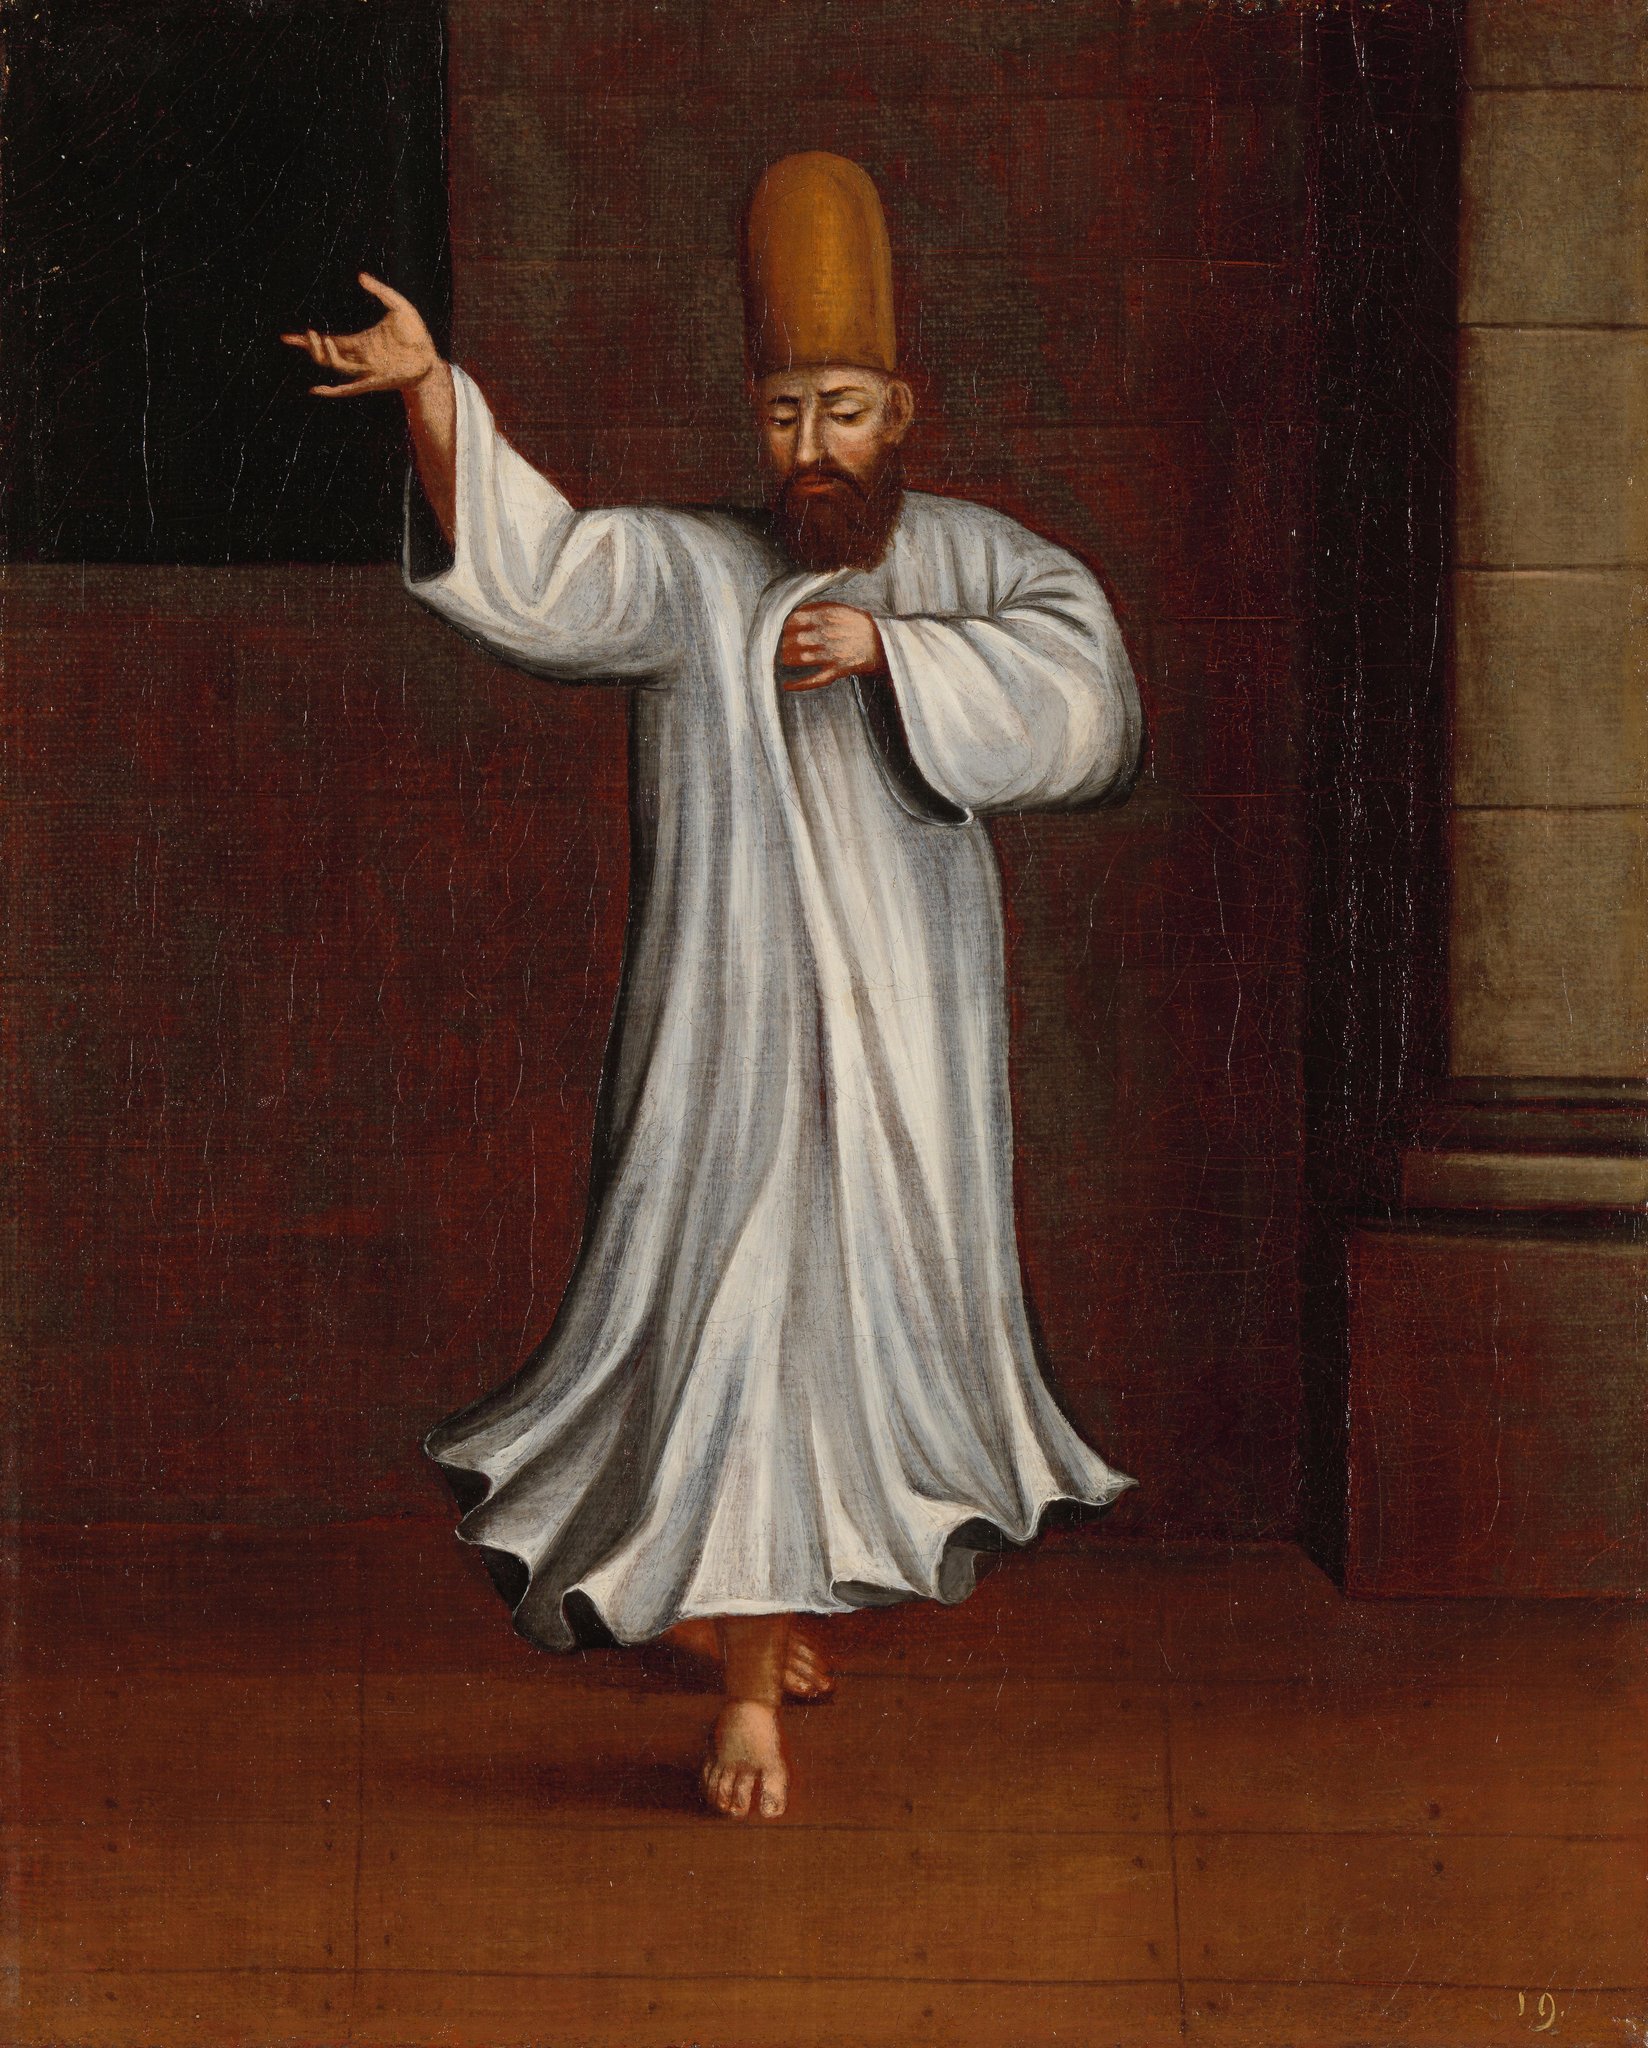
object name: painting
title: Dervish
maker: jean baptiste vanmour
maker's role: painter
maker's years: 1671-1737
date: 1700-1737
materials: canvas, oil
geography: istanbul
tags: folk costume, regional costume, fraternities ~ islam, mohammedanism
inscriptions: inscription: ‘Derweys of Turxen Heilige’, number: ‘19’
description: Een derwisj. Staande, ten voeten uit, met opgeheven rechterarm.